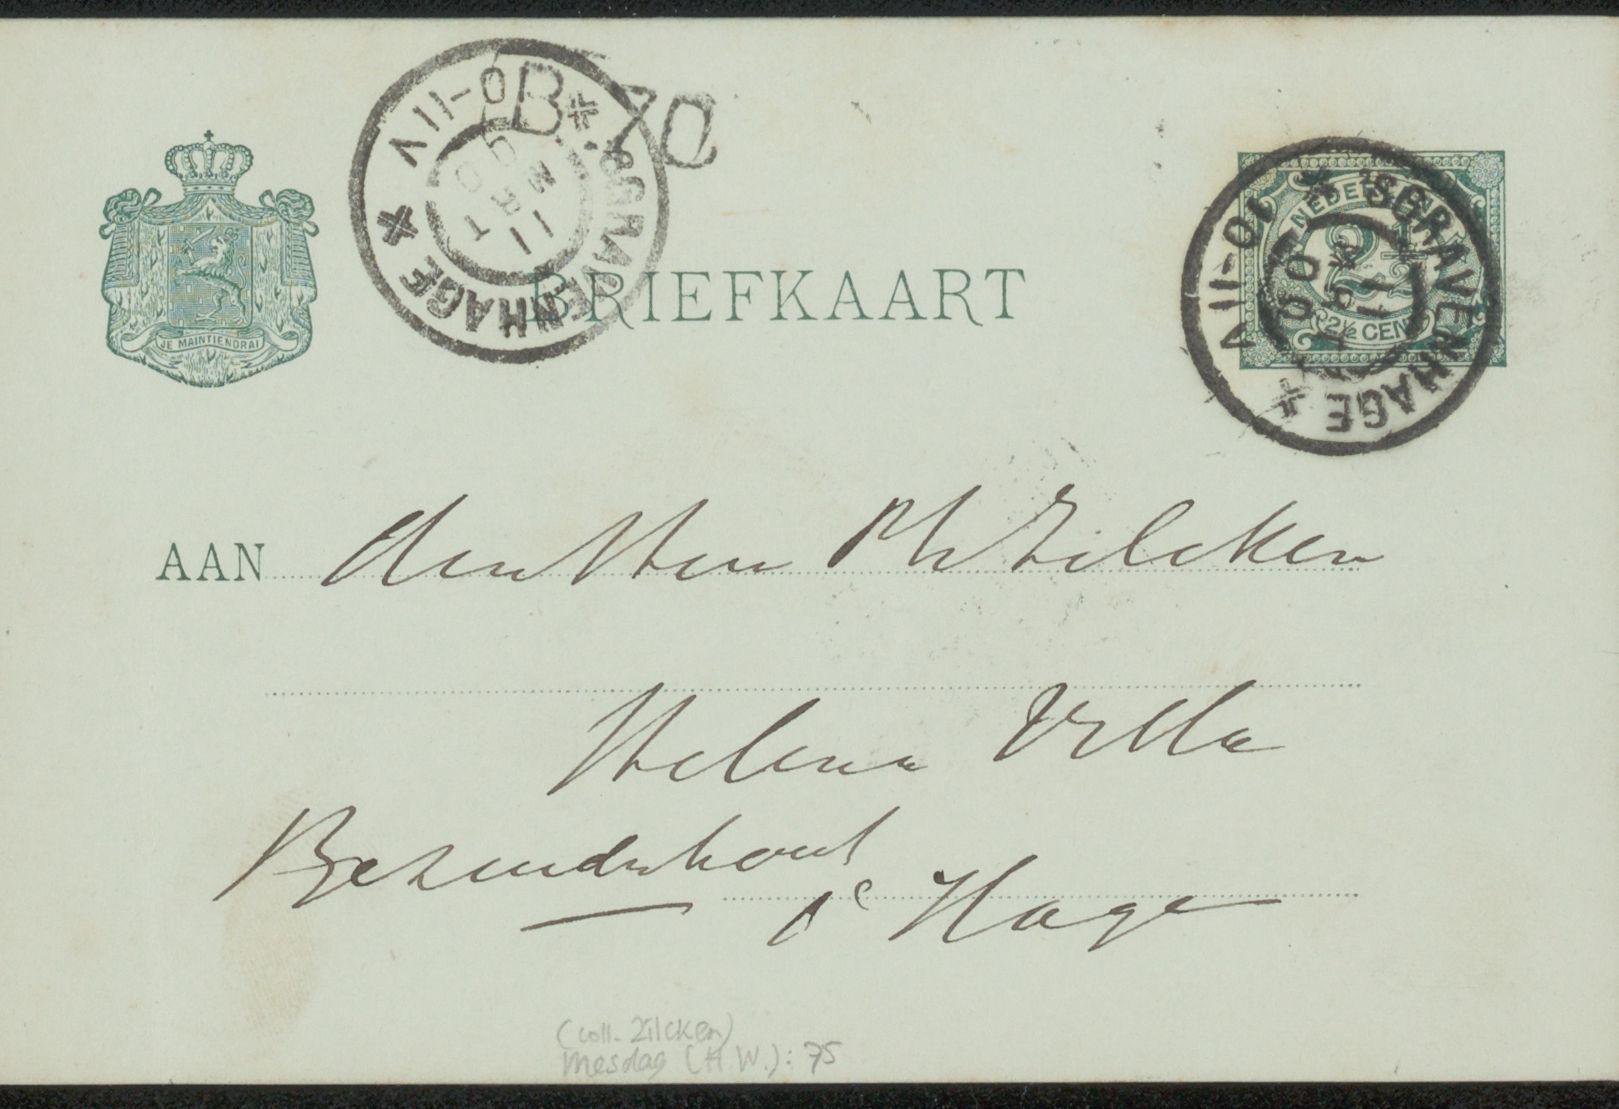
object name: postcard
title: Briefkaart aan Philip Zilcken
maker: hendrik willem mesdag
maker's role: draughtsman, painter, print maker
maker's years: 1831-1915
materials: cardboard, ink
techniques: pen, writing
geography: the hague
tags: the hague, draughtsman, philip zilcken